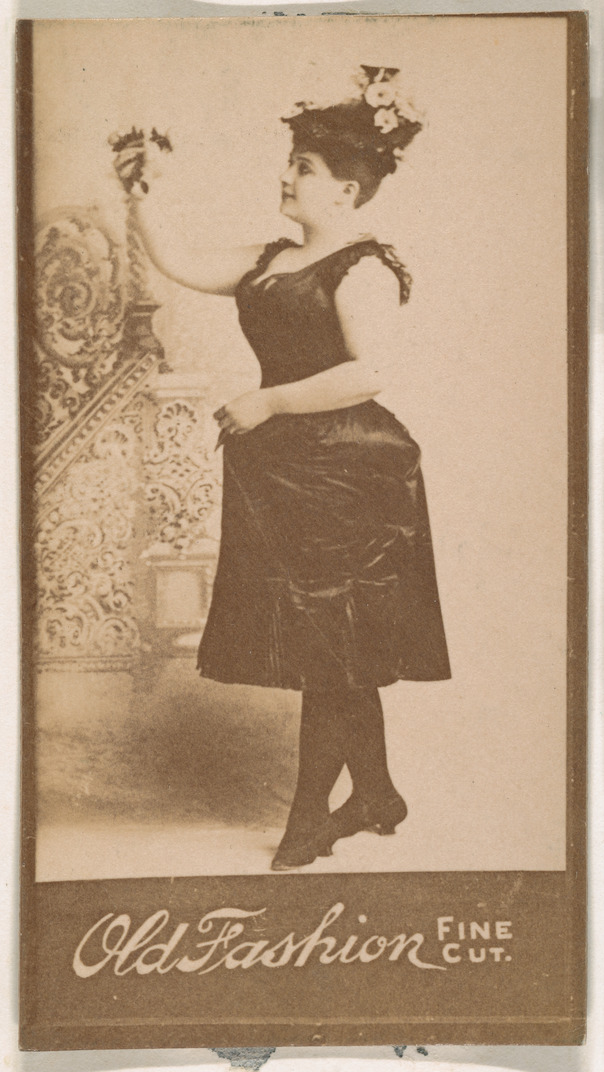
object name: photograph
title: Portrait of actress, from the Actresses series (N664) promoting Old Fashion Fine Cut Tobacco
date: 1888-1890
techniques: albumen silver print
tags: portraits,women,actresses